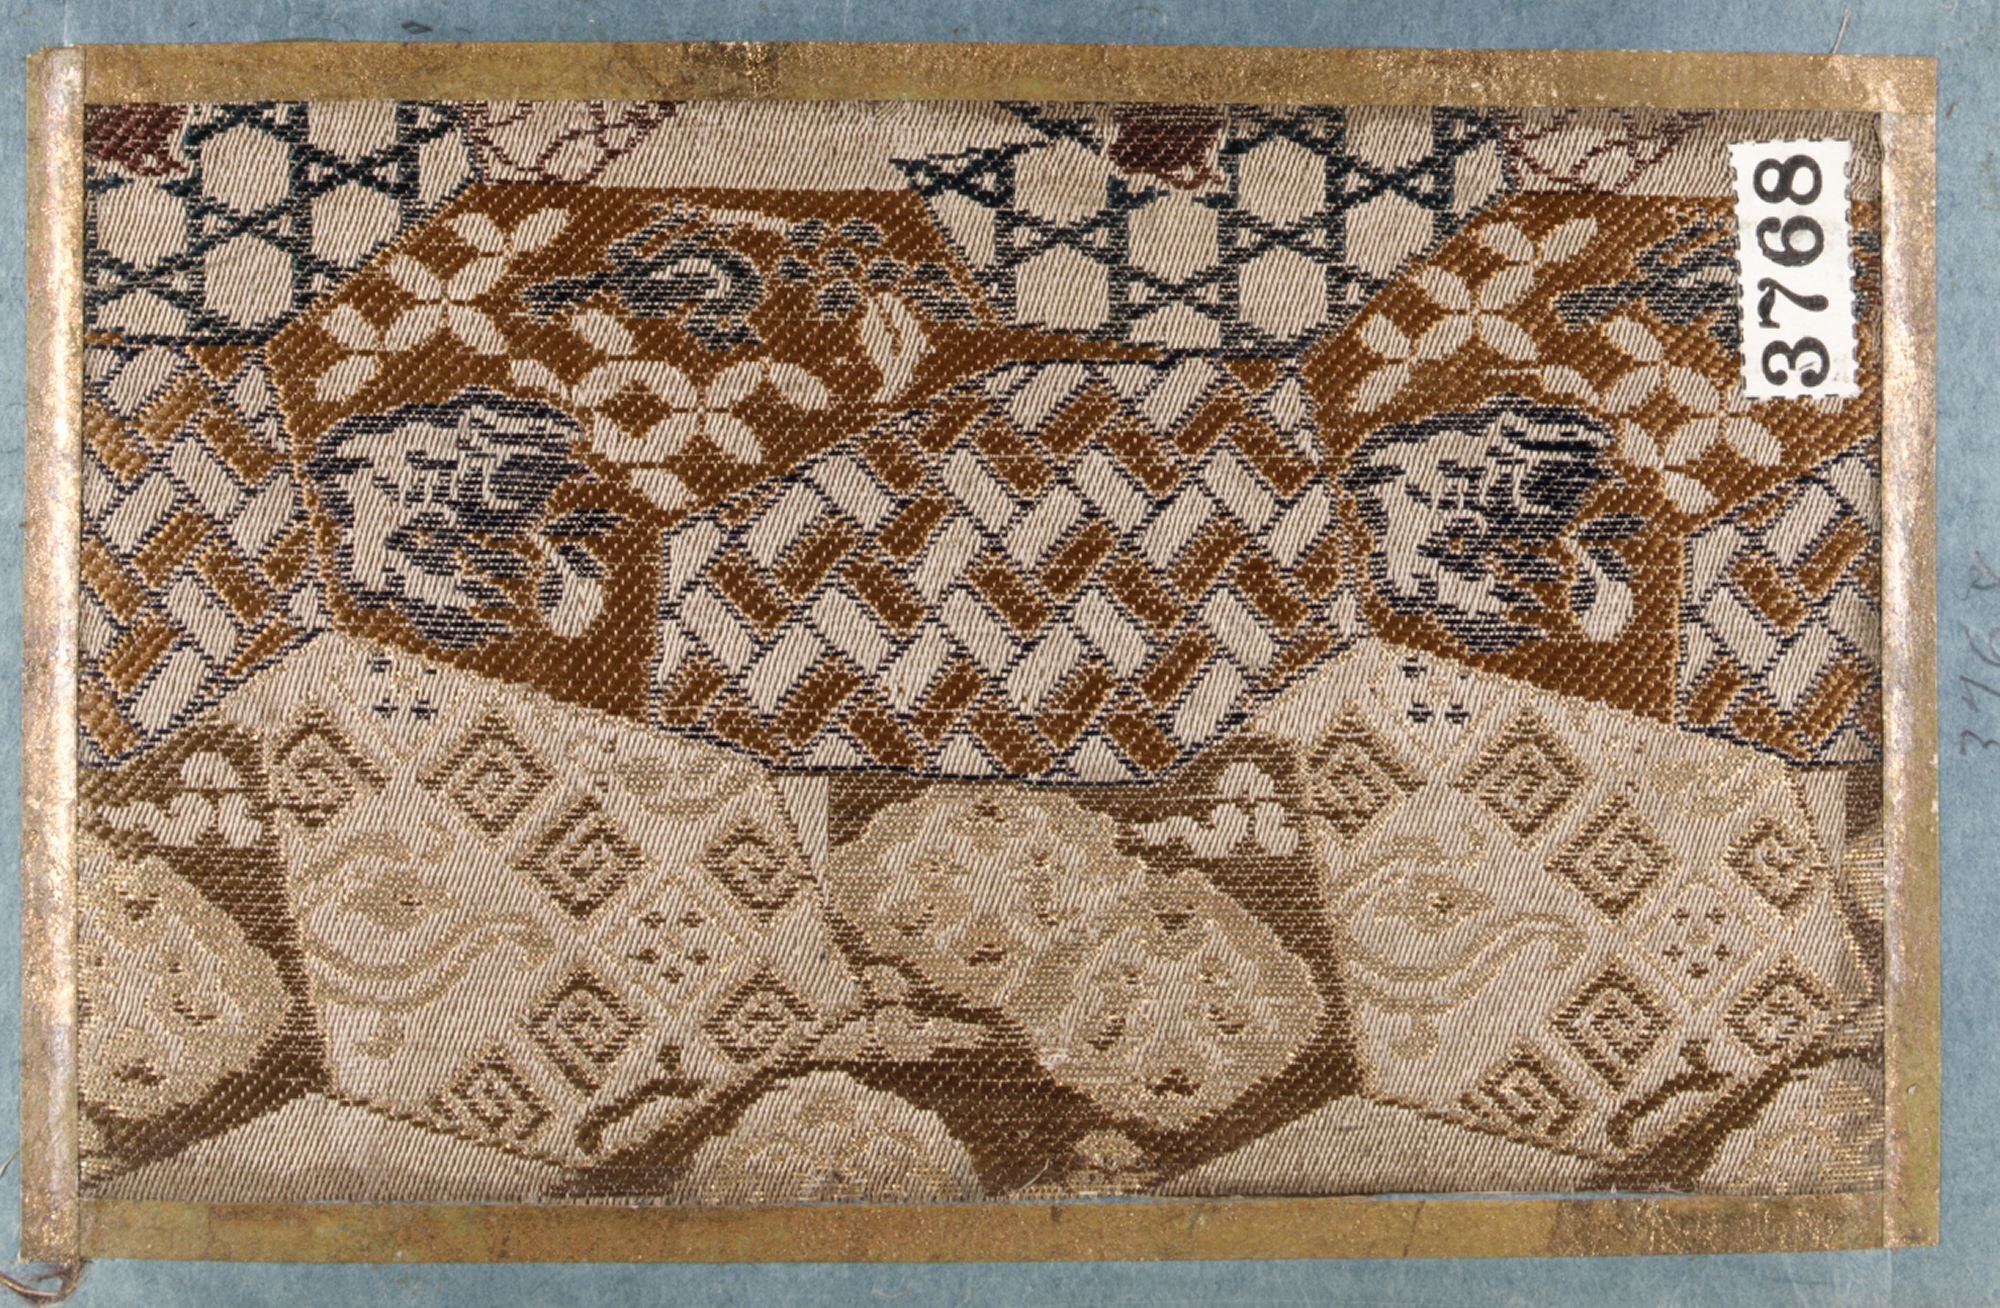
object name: sample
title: Textile Sample from Sample Book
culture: japanese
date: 1801-1900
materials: silk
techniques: tapestry